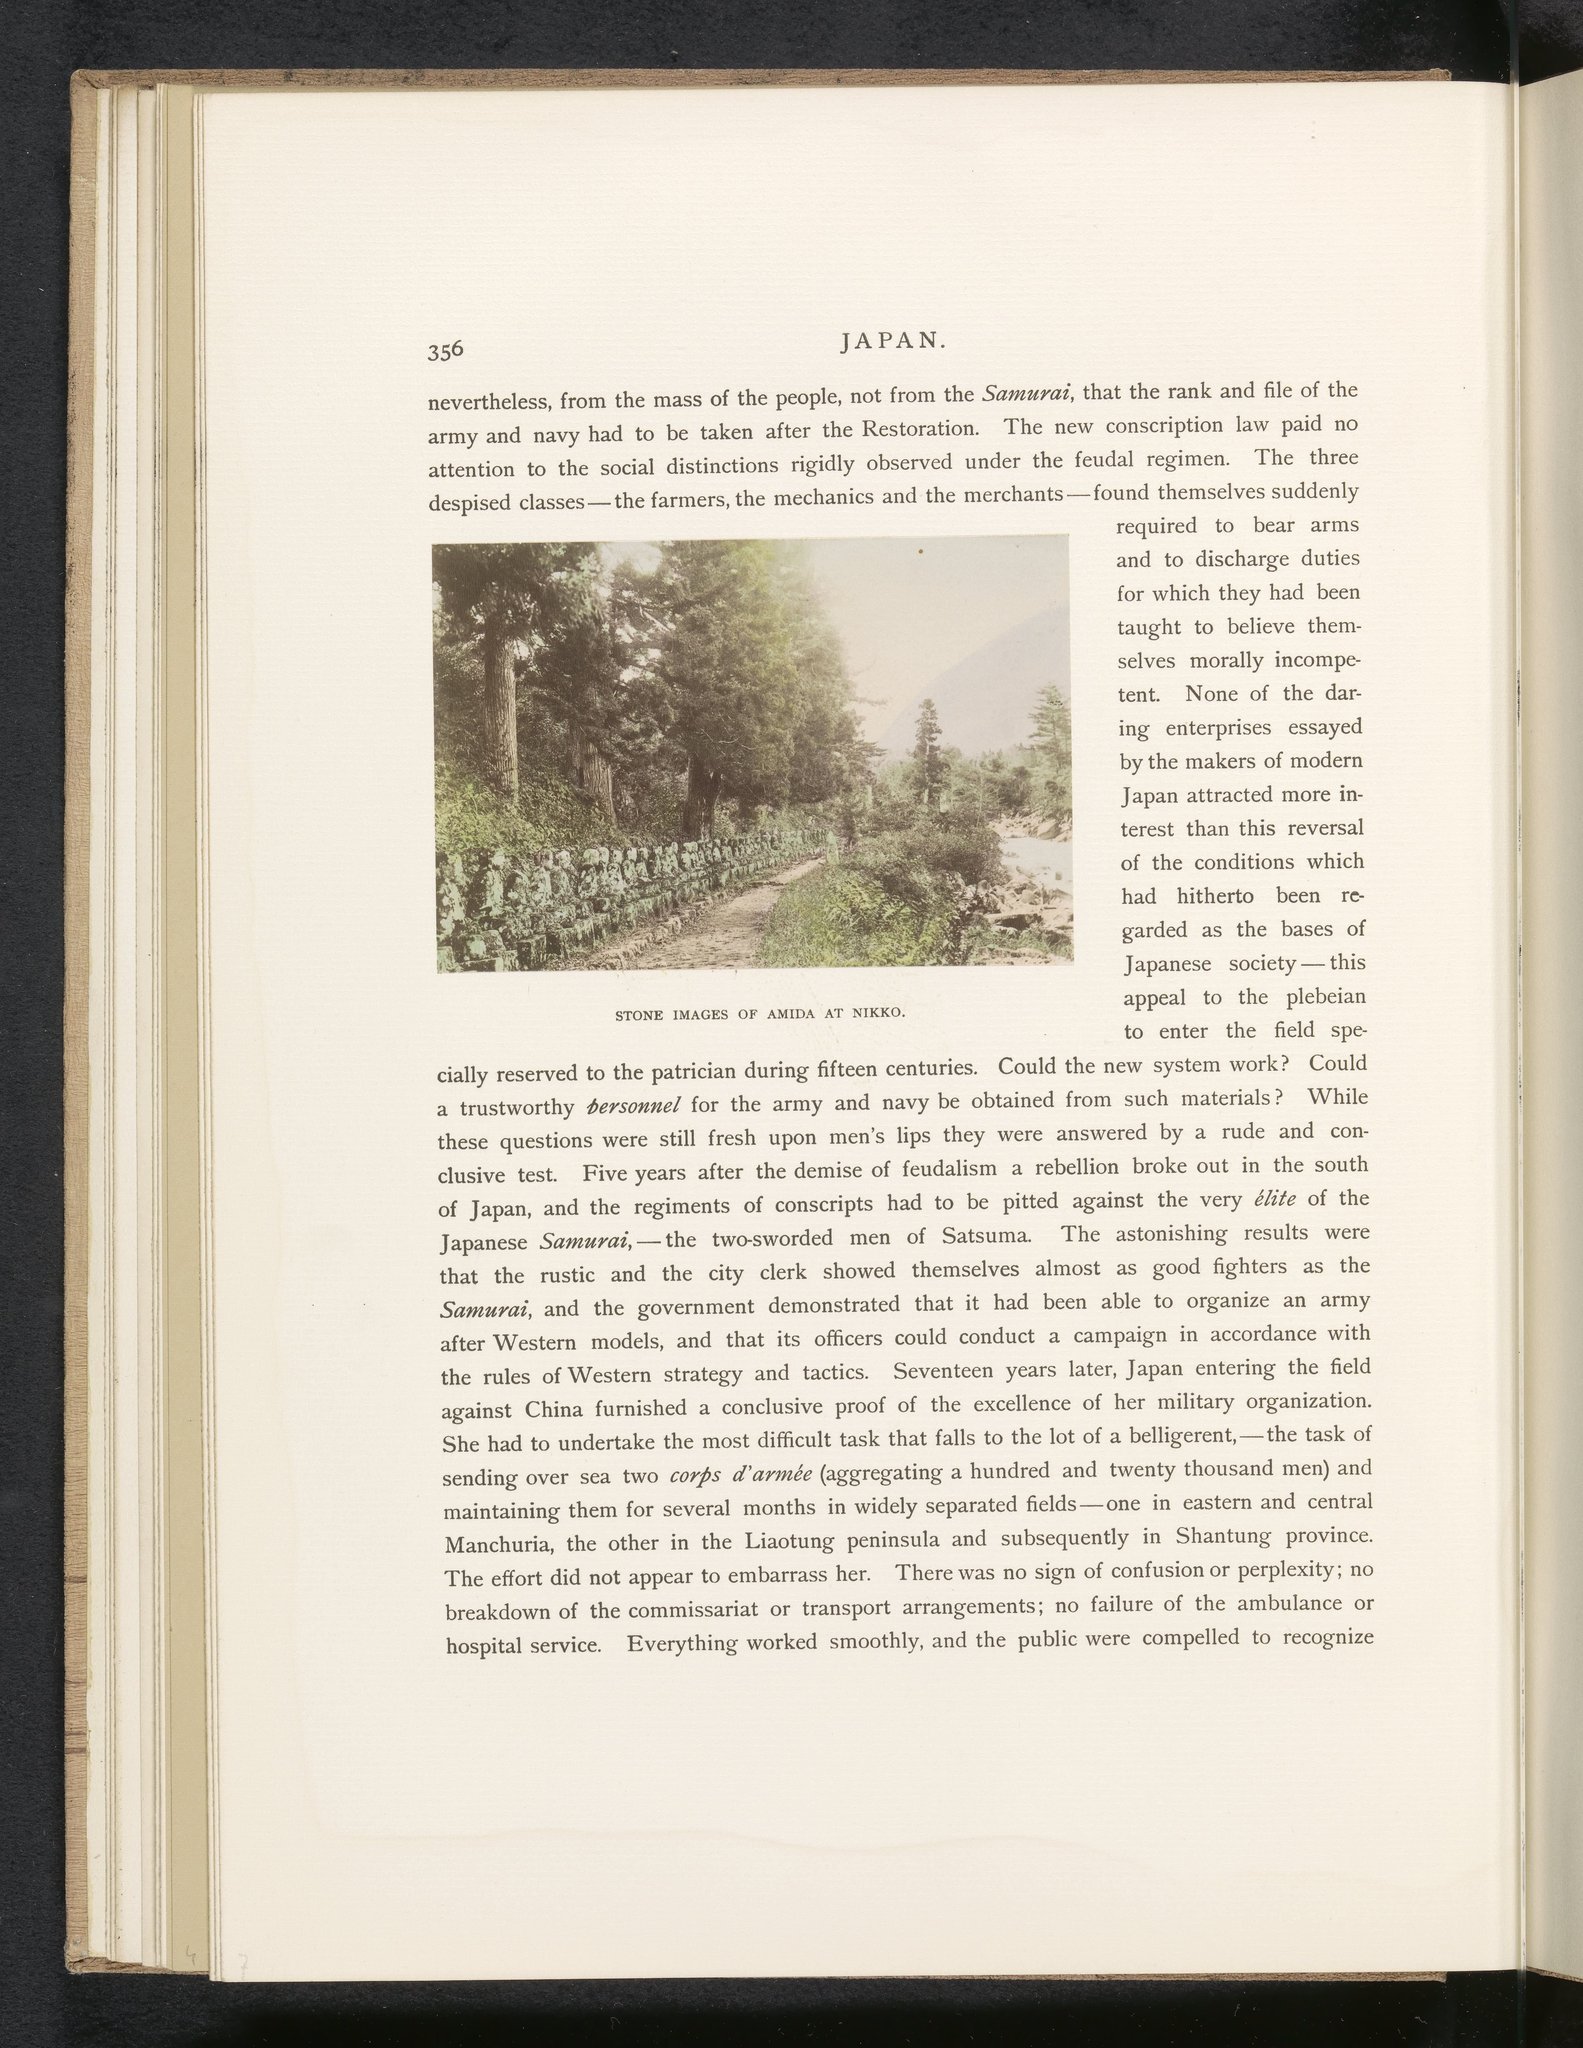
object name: page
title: Stone images of Amida at Nikko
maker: Anonymous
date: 1888-1898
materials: photographic support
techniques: albumen print, hand coloring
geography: nikko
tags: hinduism, buddhism, jainism, sculpture, public road